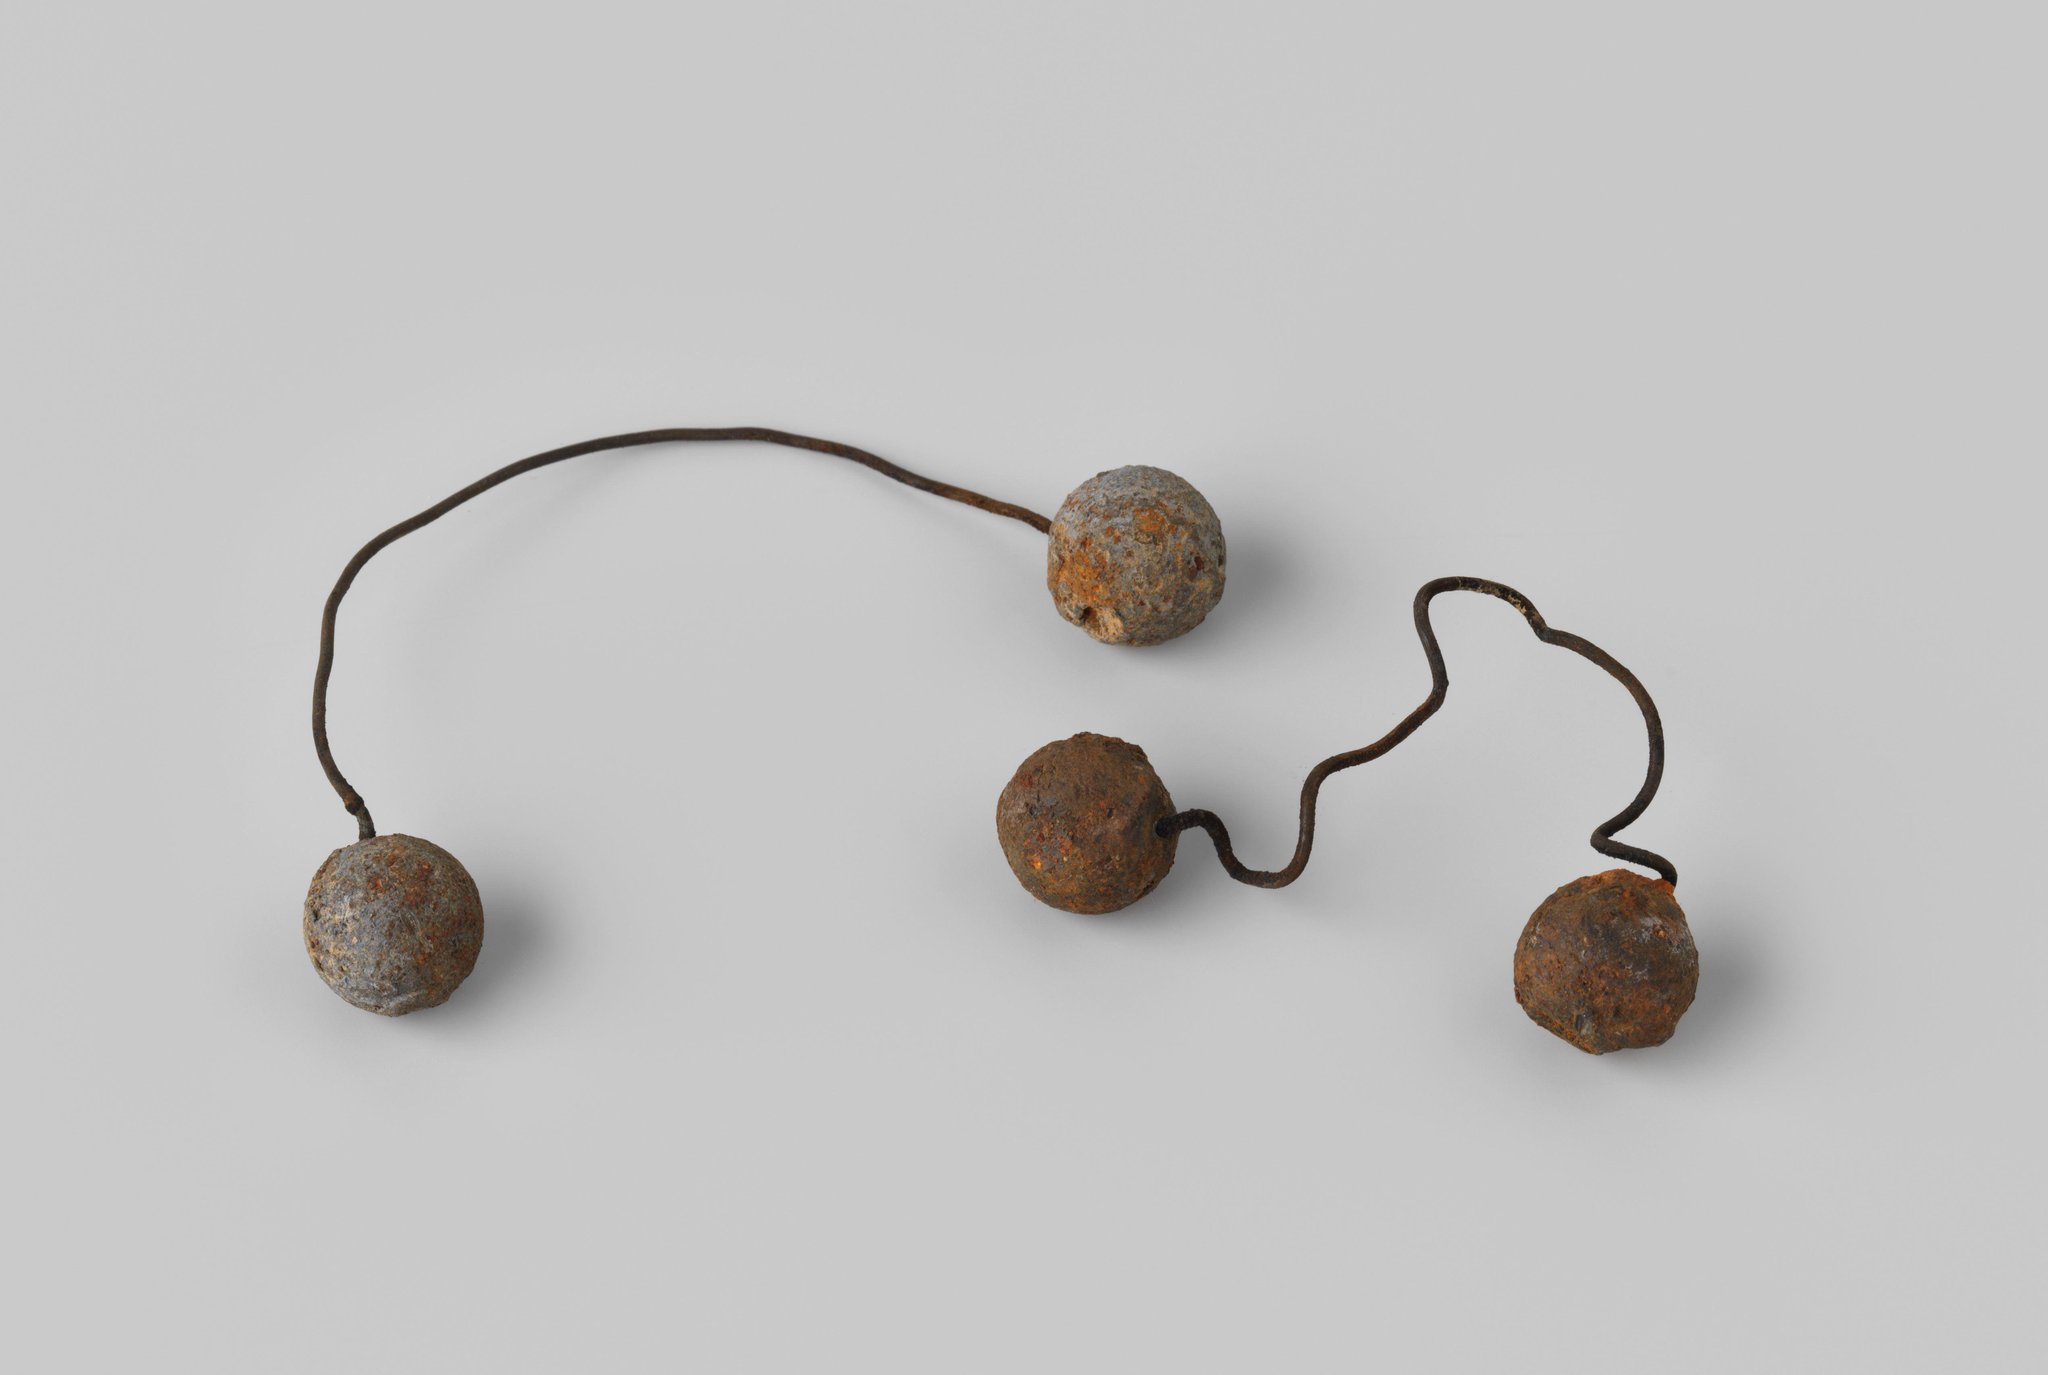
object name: chain shot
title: Two-ball springshot from the wreck of the Dutch East Indiaman Hollandia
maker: Anonymous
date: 1700-1743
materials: lead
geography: netherlands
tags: verenigde oostindische compagnie, hollandia (schip), annet